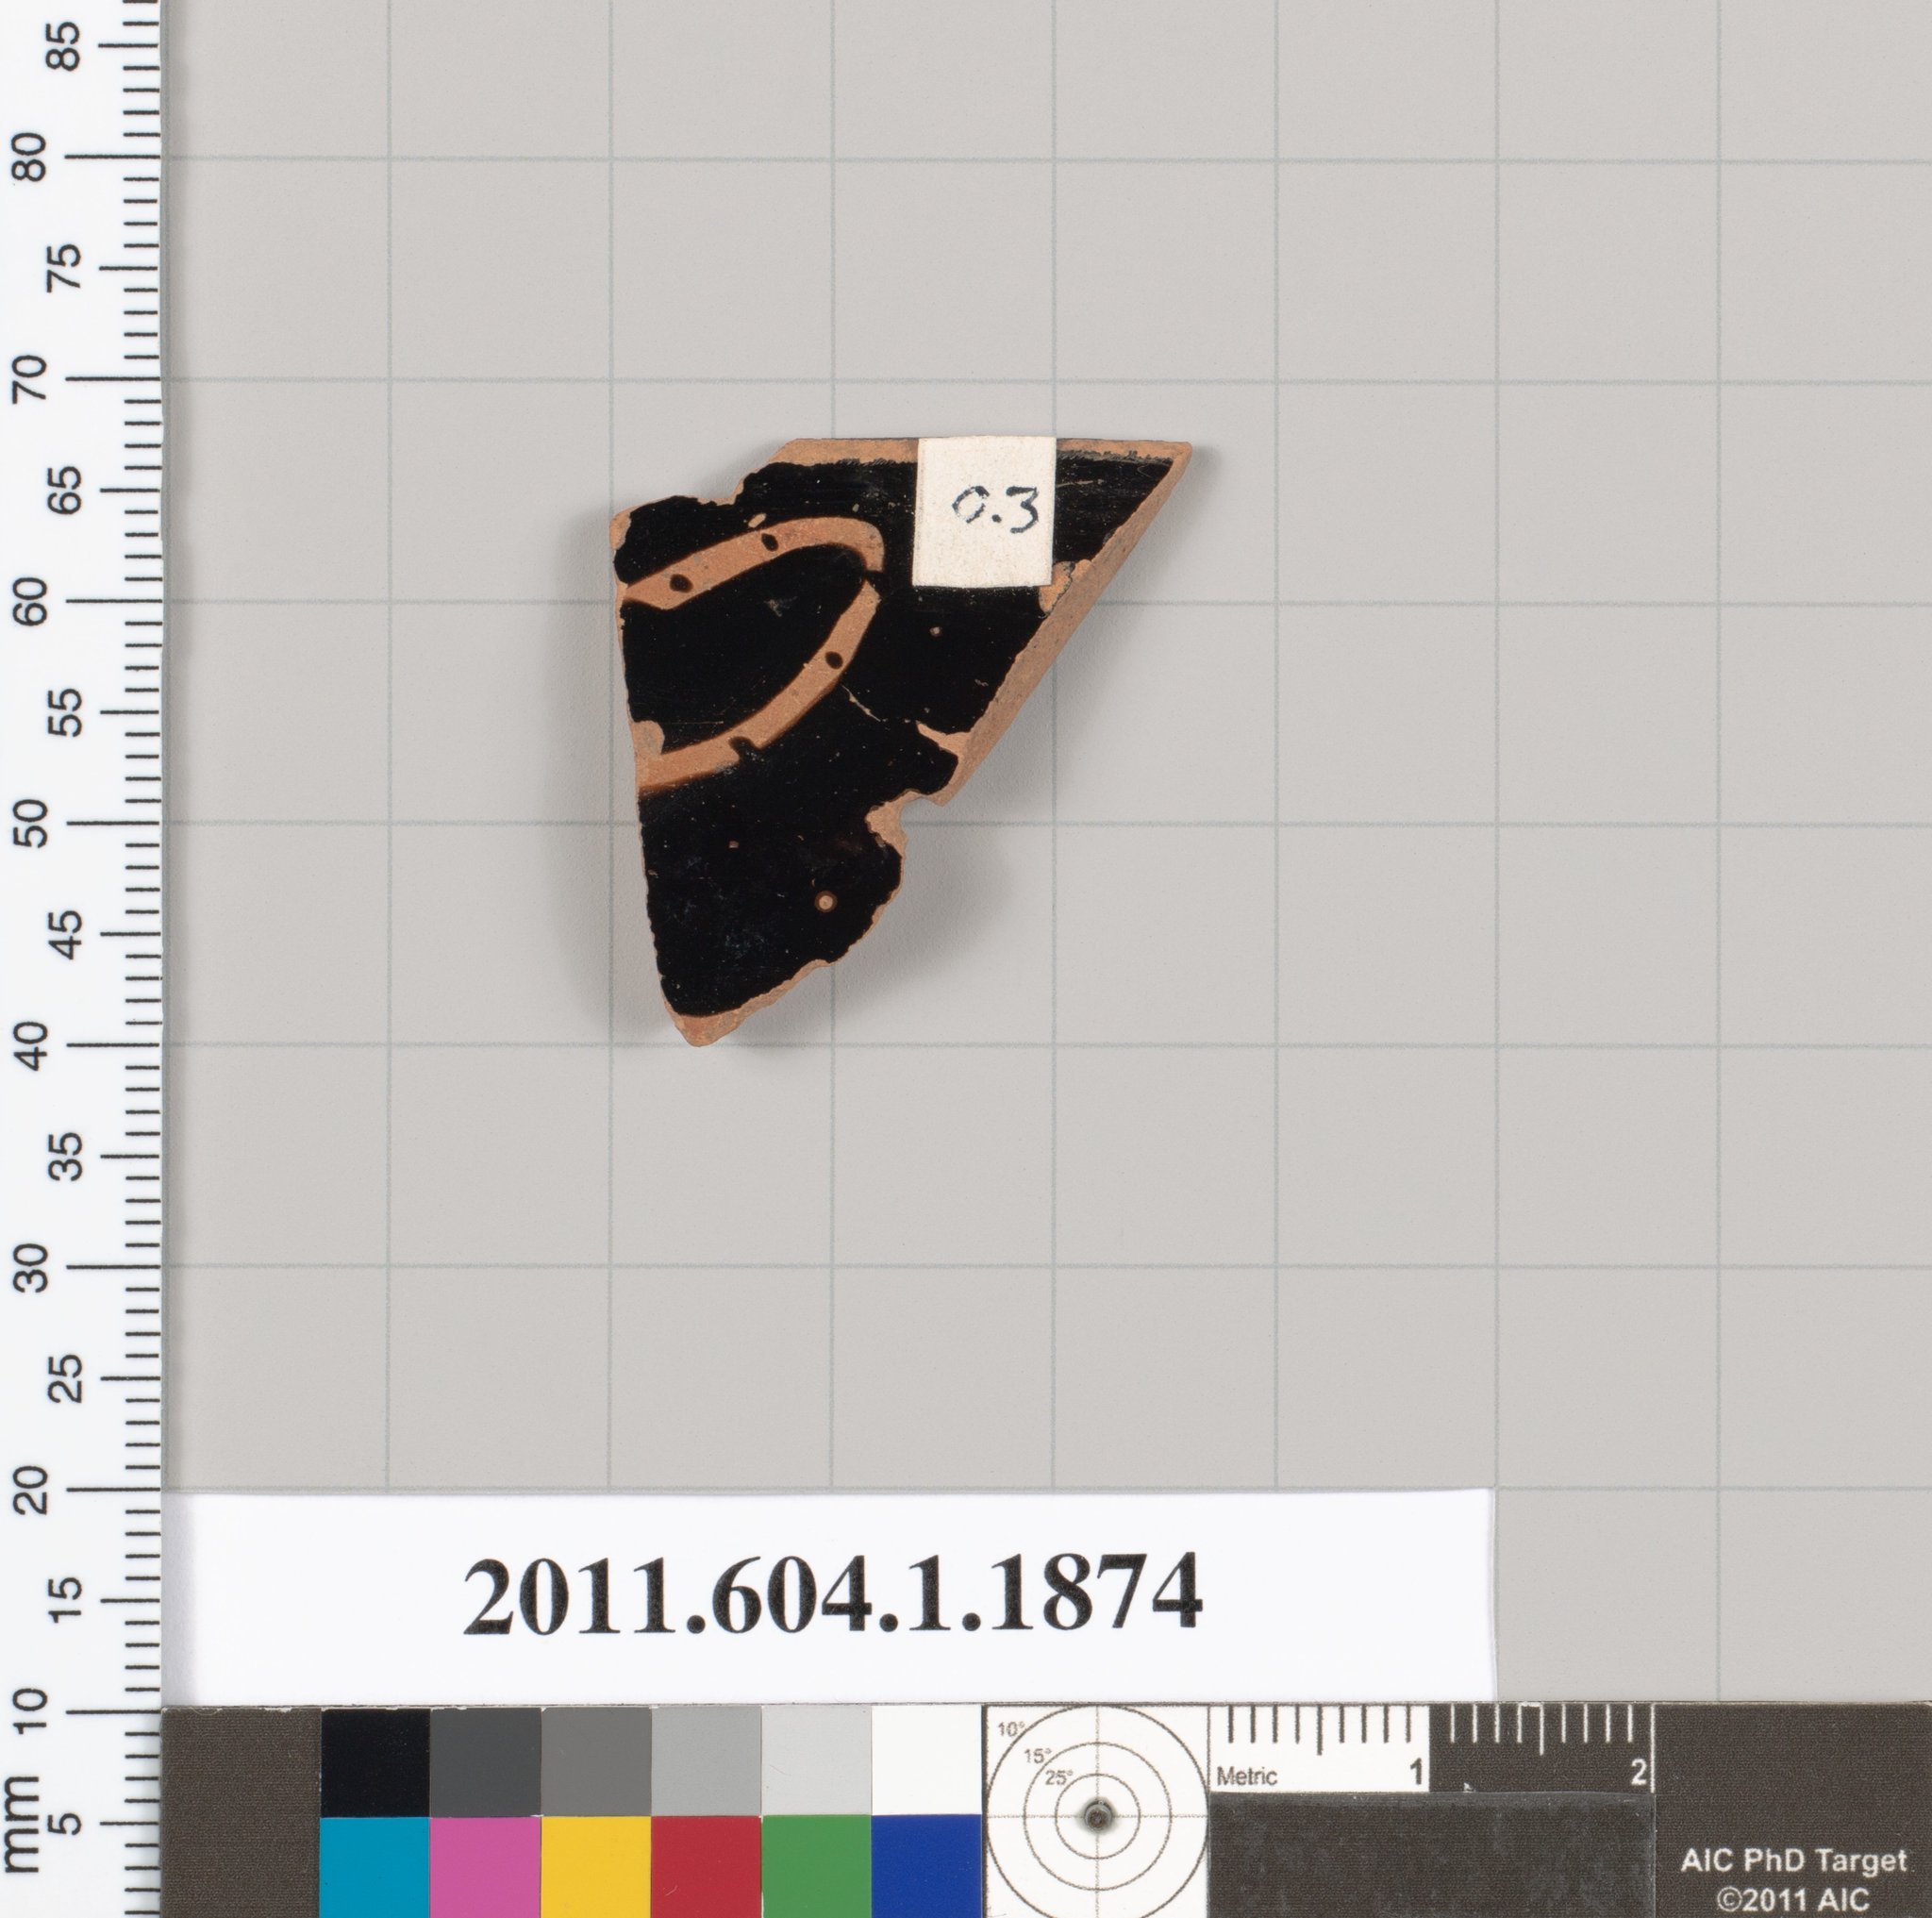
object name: kylix fragment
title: Terracotta rim fragment of a kylix (drinking cup)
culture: greek, attic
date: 475-451 BCE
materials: terracotta